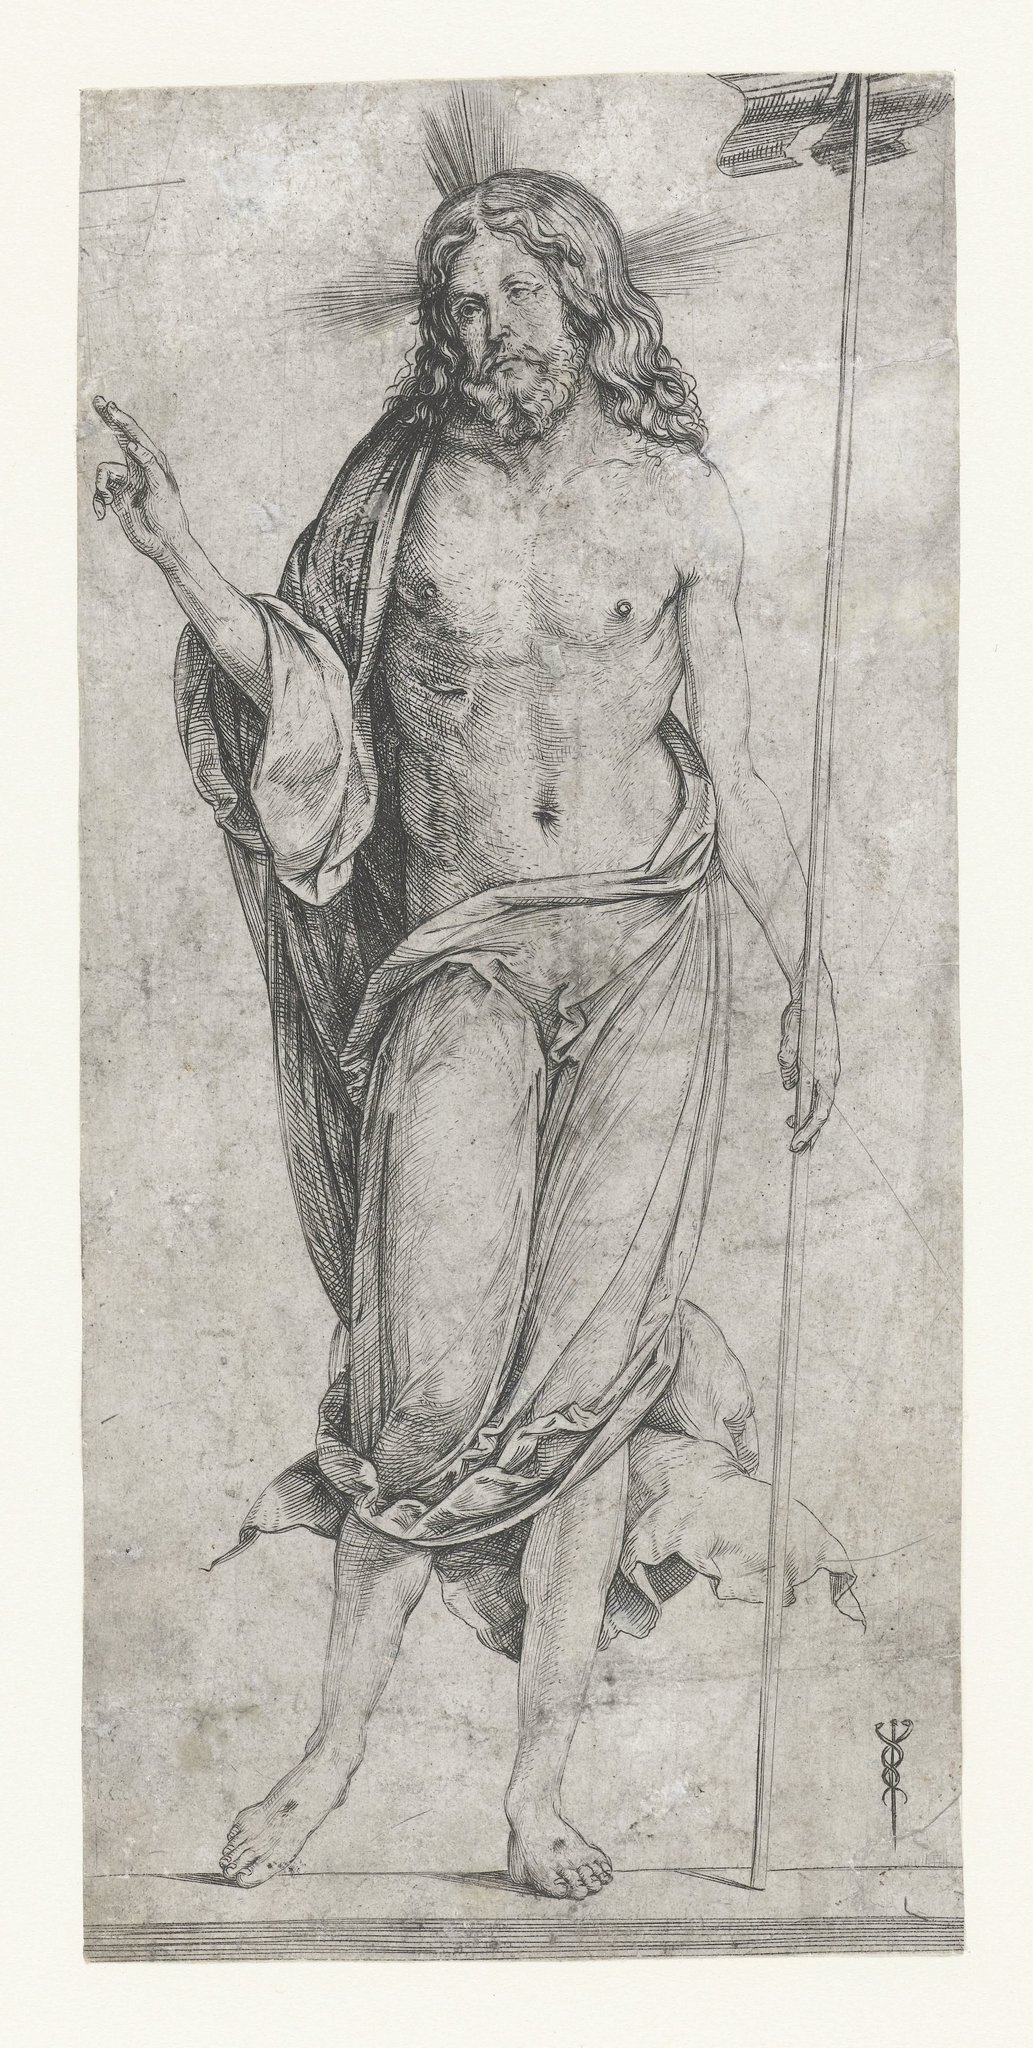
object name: print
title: Staande Christus als Salvator Mundi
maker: jacopo de barbari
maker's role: draughtsman, print maker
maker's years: 1440-1516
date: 1503-1509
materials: paper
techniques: engraving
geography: italy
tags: 'salvator mundi', making a blessing gesture; an orb in his hand or at his feet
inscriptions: collector's mark: Lugt 240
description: De prent dateert van voor 1508 of 1509 toen Lucas Cranach de Christus figuur gebruikte voor zijn altaarstuk, nu in de Gemäldegalerie, Kassel (zie documentatie).